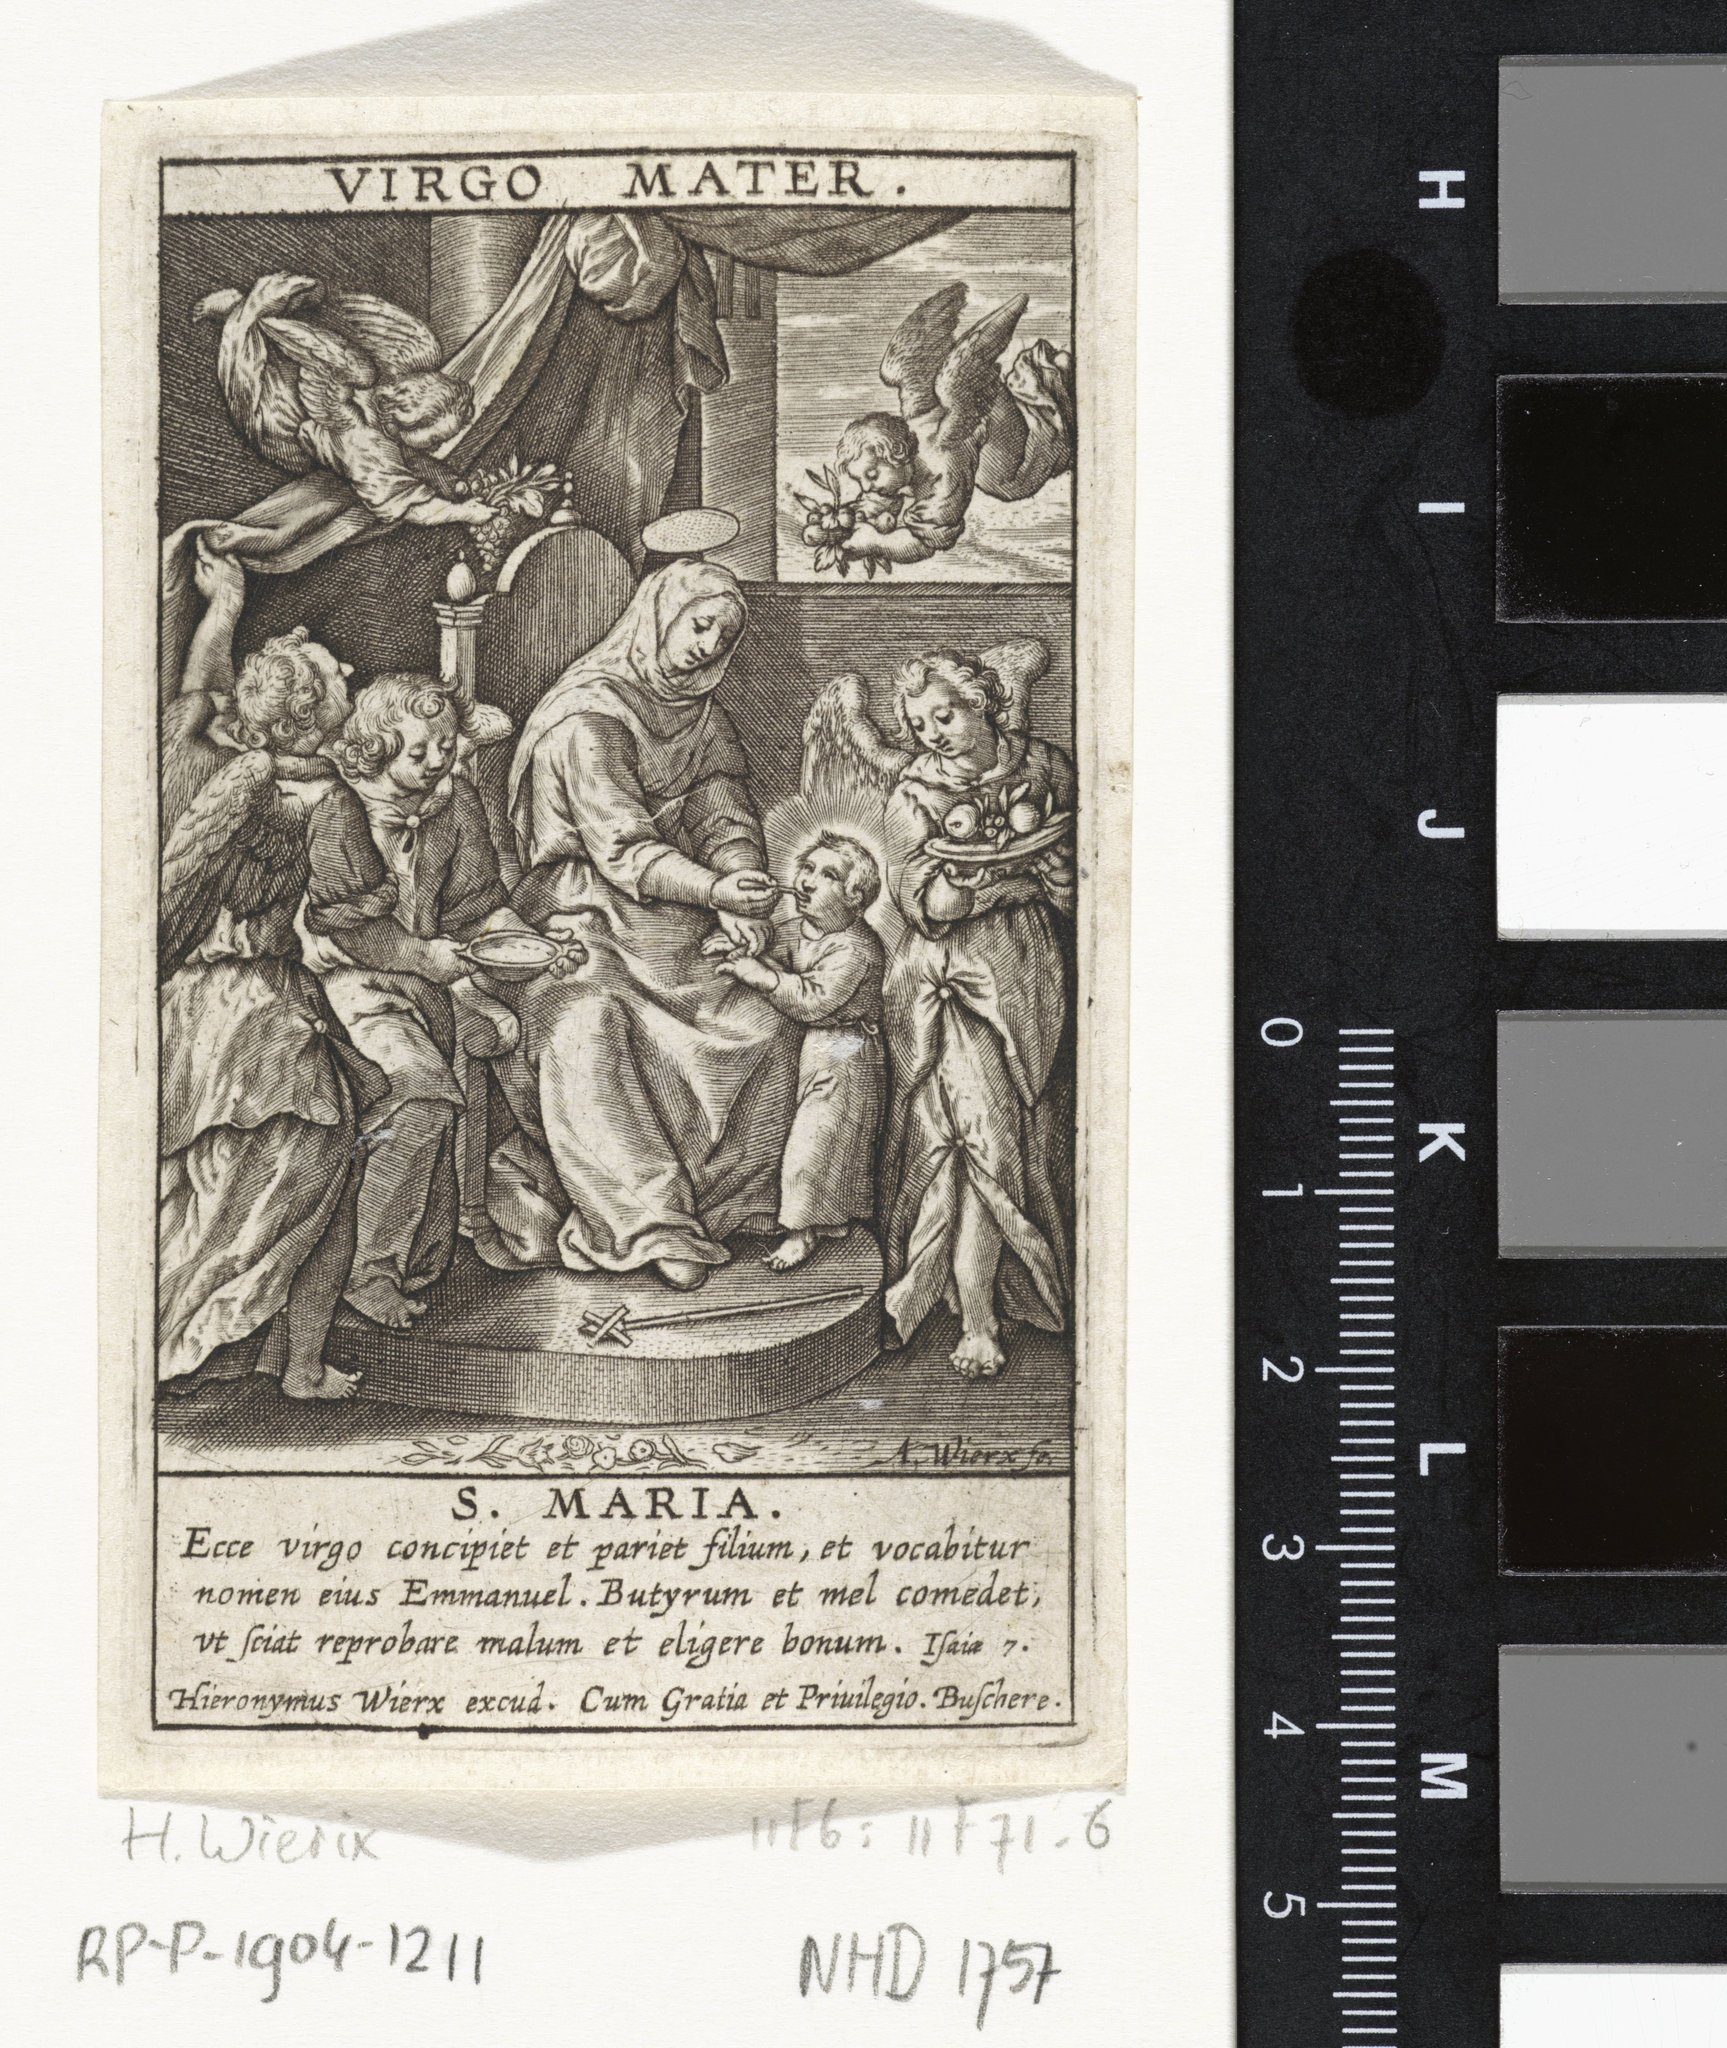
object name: print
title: Virgo Mater S. Maria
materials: paper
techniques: engraving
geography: antwerp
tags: specific aspects of christ-child and mary ~ madonna-representations (n.b. secondary notation only) (+ angel(s)), feeding a baby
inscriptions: collector's mark: Lugt 2228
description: Maria voedt het Christuskind dat voor haar staat. De engel die naast haar troon staat houdt een bord vast, terwijl Maria een lepel in de mond van Christus stopt. Andere engelen brengen vruchten. In de marge een drieregelig Bijbelcitaat uit Jes. 7 in het Latijn.